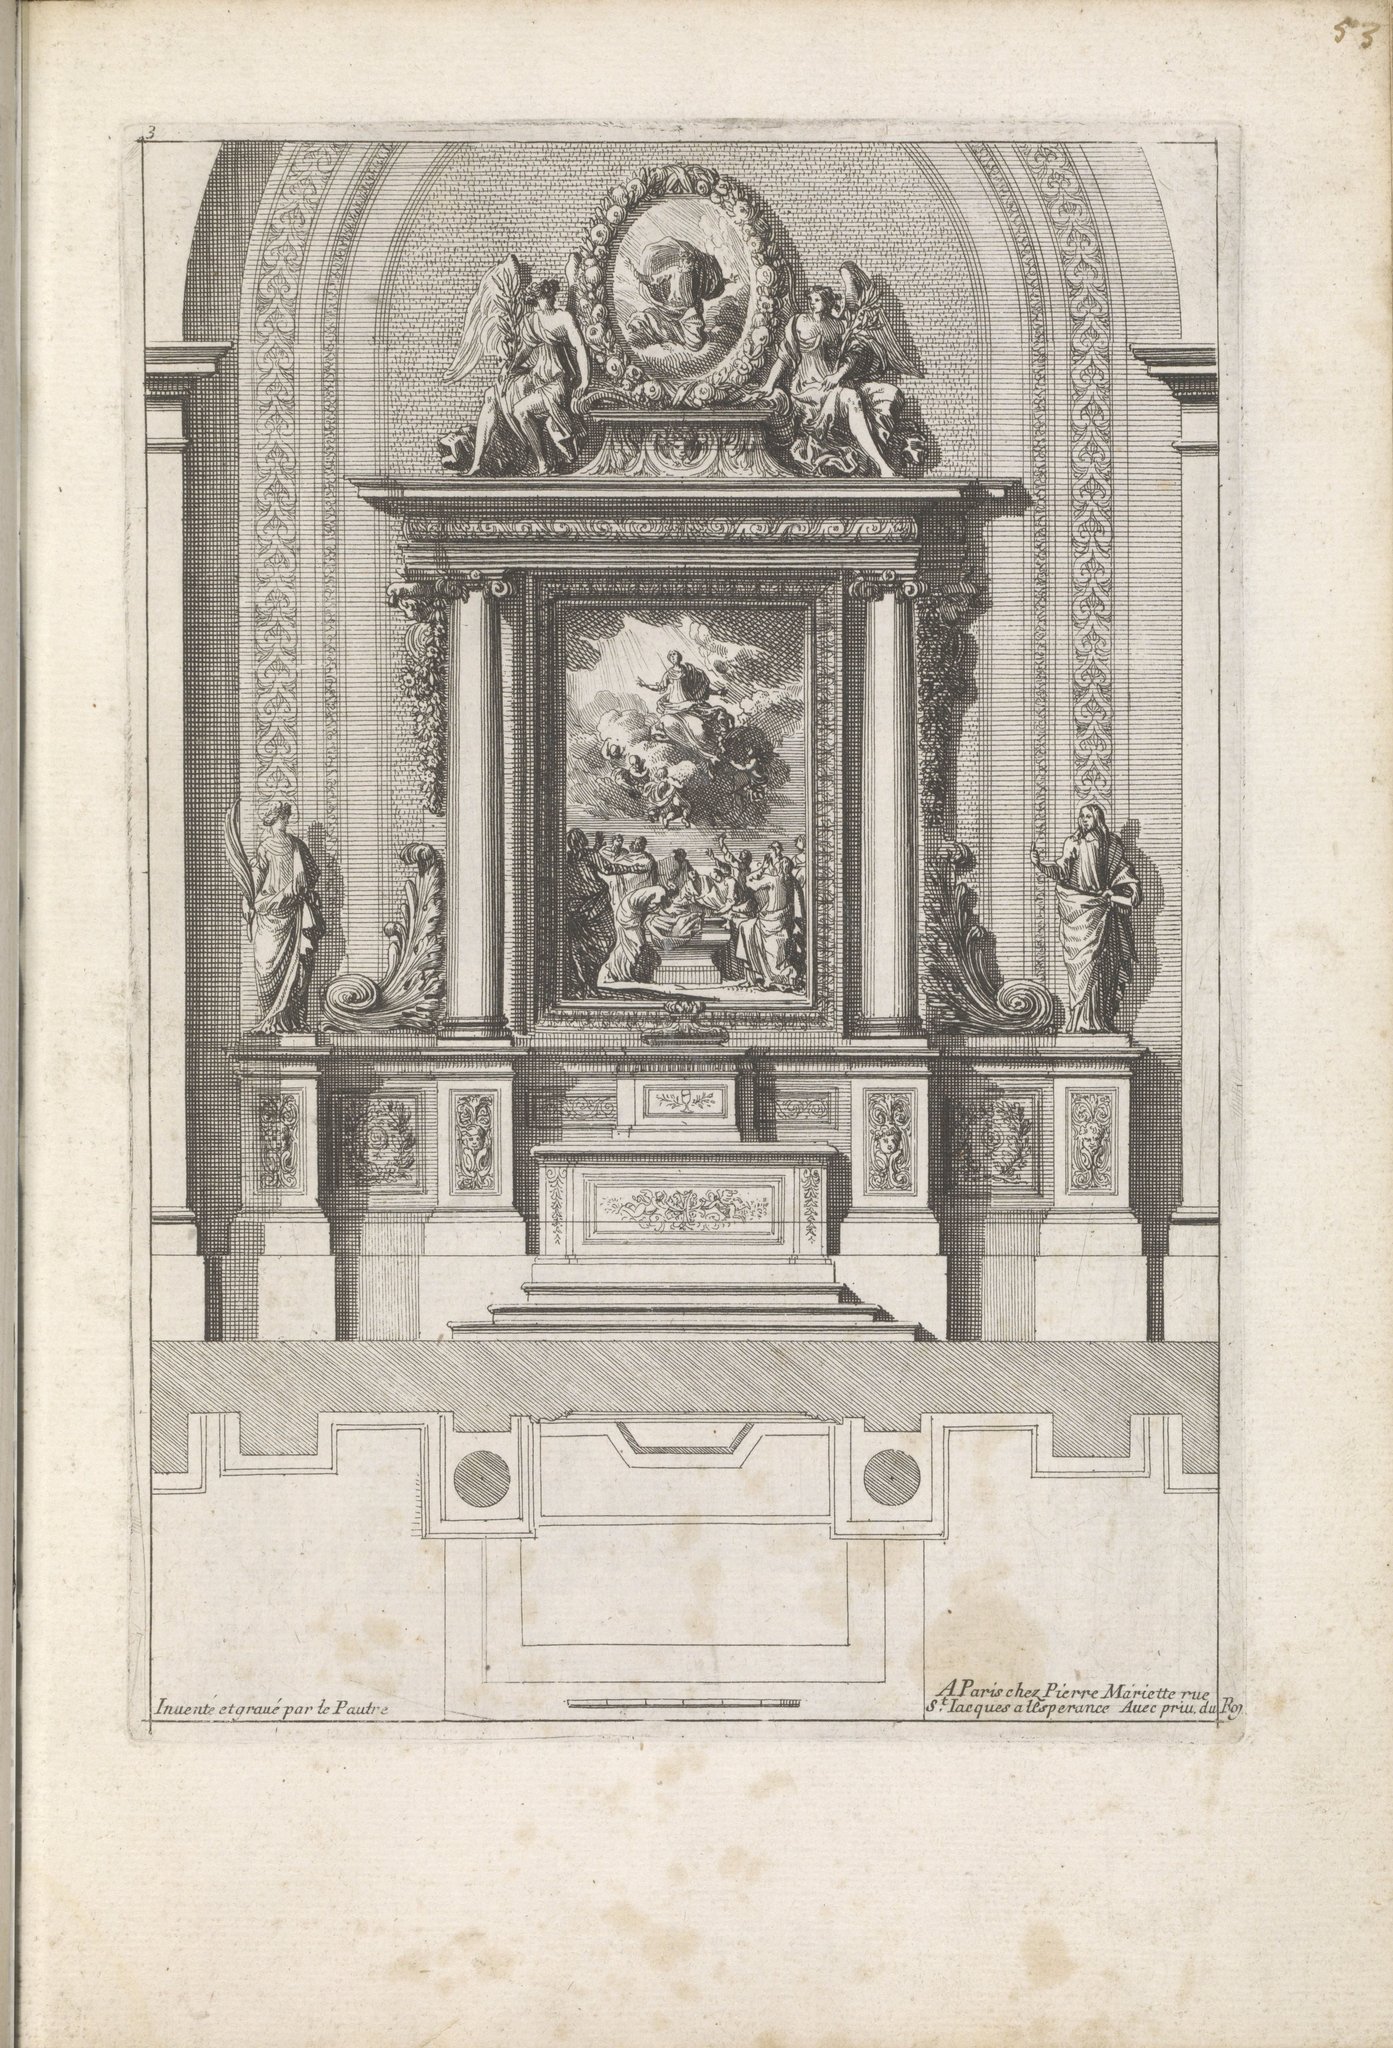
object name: ornament print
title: Retables d'autels à l'italienne (...)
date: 1658-1670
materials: paper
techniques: etching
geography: paris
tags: adoration of the kings: the wise men present their gifts to the christ-child (gold, frankincense and myrrh), altar with altar-piece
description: Altaar met een schilderij van de Aanbidding door de koningen. In de kerk staan groepjes figuren. Prent maakt deel uit van een album.